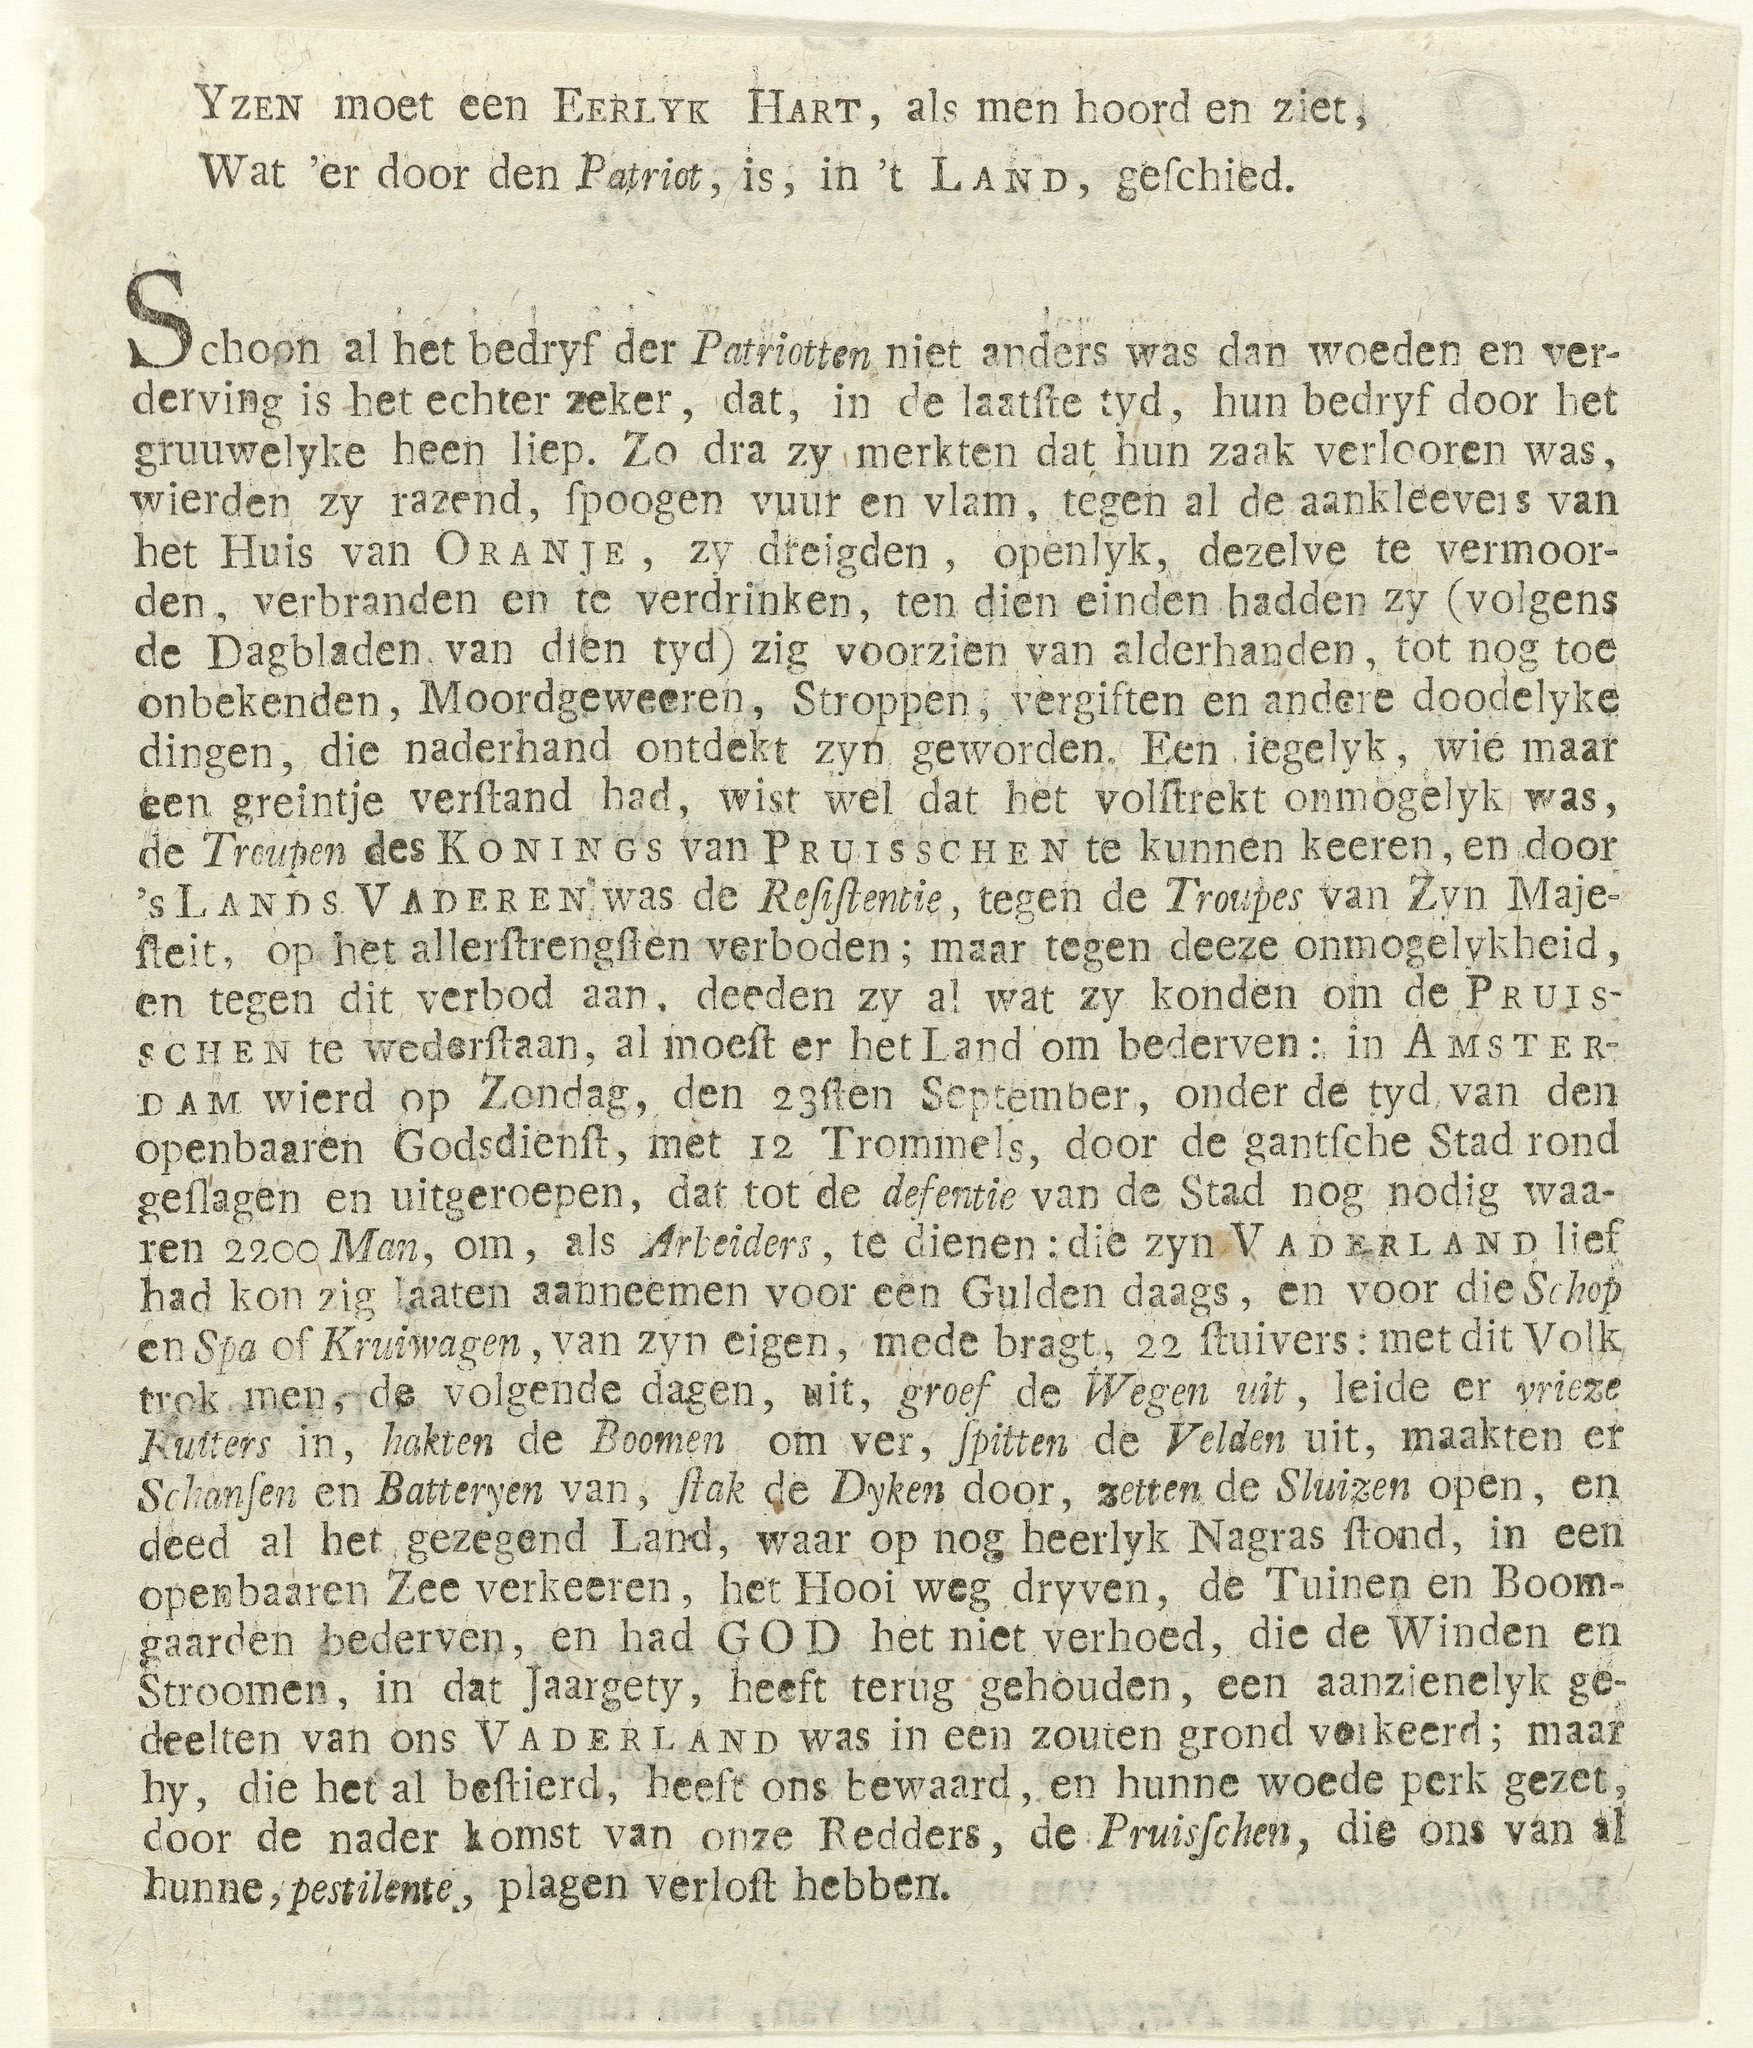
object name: text sheet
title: Verhaal van de verwoestingen bij de uittocht van de patriotten, 1787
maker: Anonymous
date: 1787-1790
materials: paper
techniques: letterpress printing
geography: northern netherlands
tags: utrecht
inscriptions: collector's mark: Lugt 2228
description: Uitgeknipt tekstblad met het verhaal van de verwoestingen en plunderingen aangericht door de patriotten tijdens de uittocht uit Utrecht en Holland in september 1787, bij het naderen van de Pruisische troepen. Op de achterzijde verzen bij de letters Y en Z. Blaadje bij de prent behorend bij de letter Y uit een ABC boek.